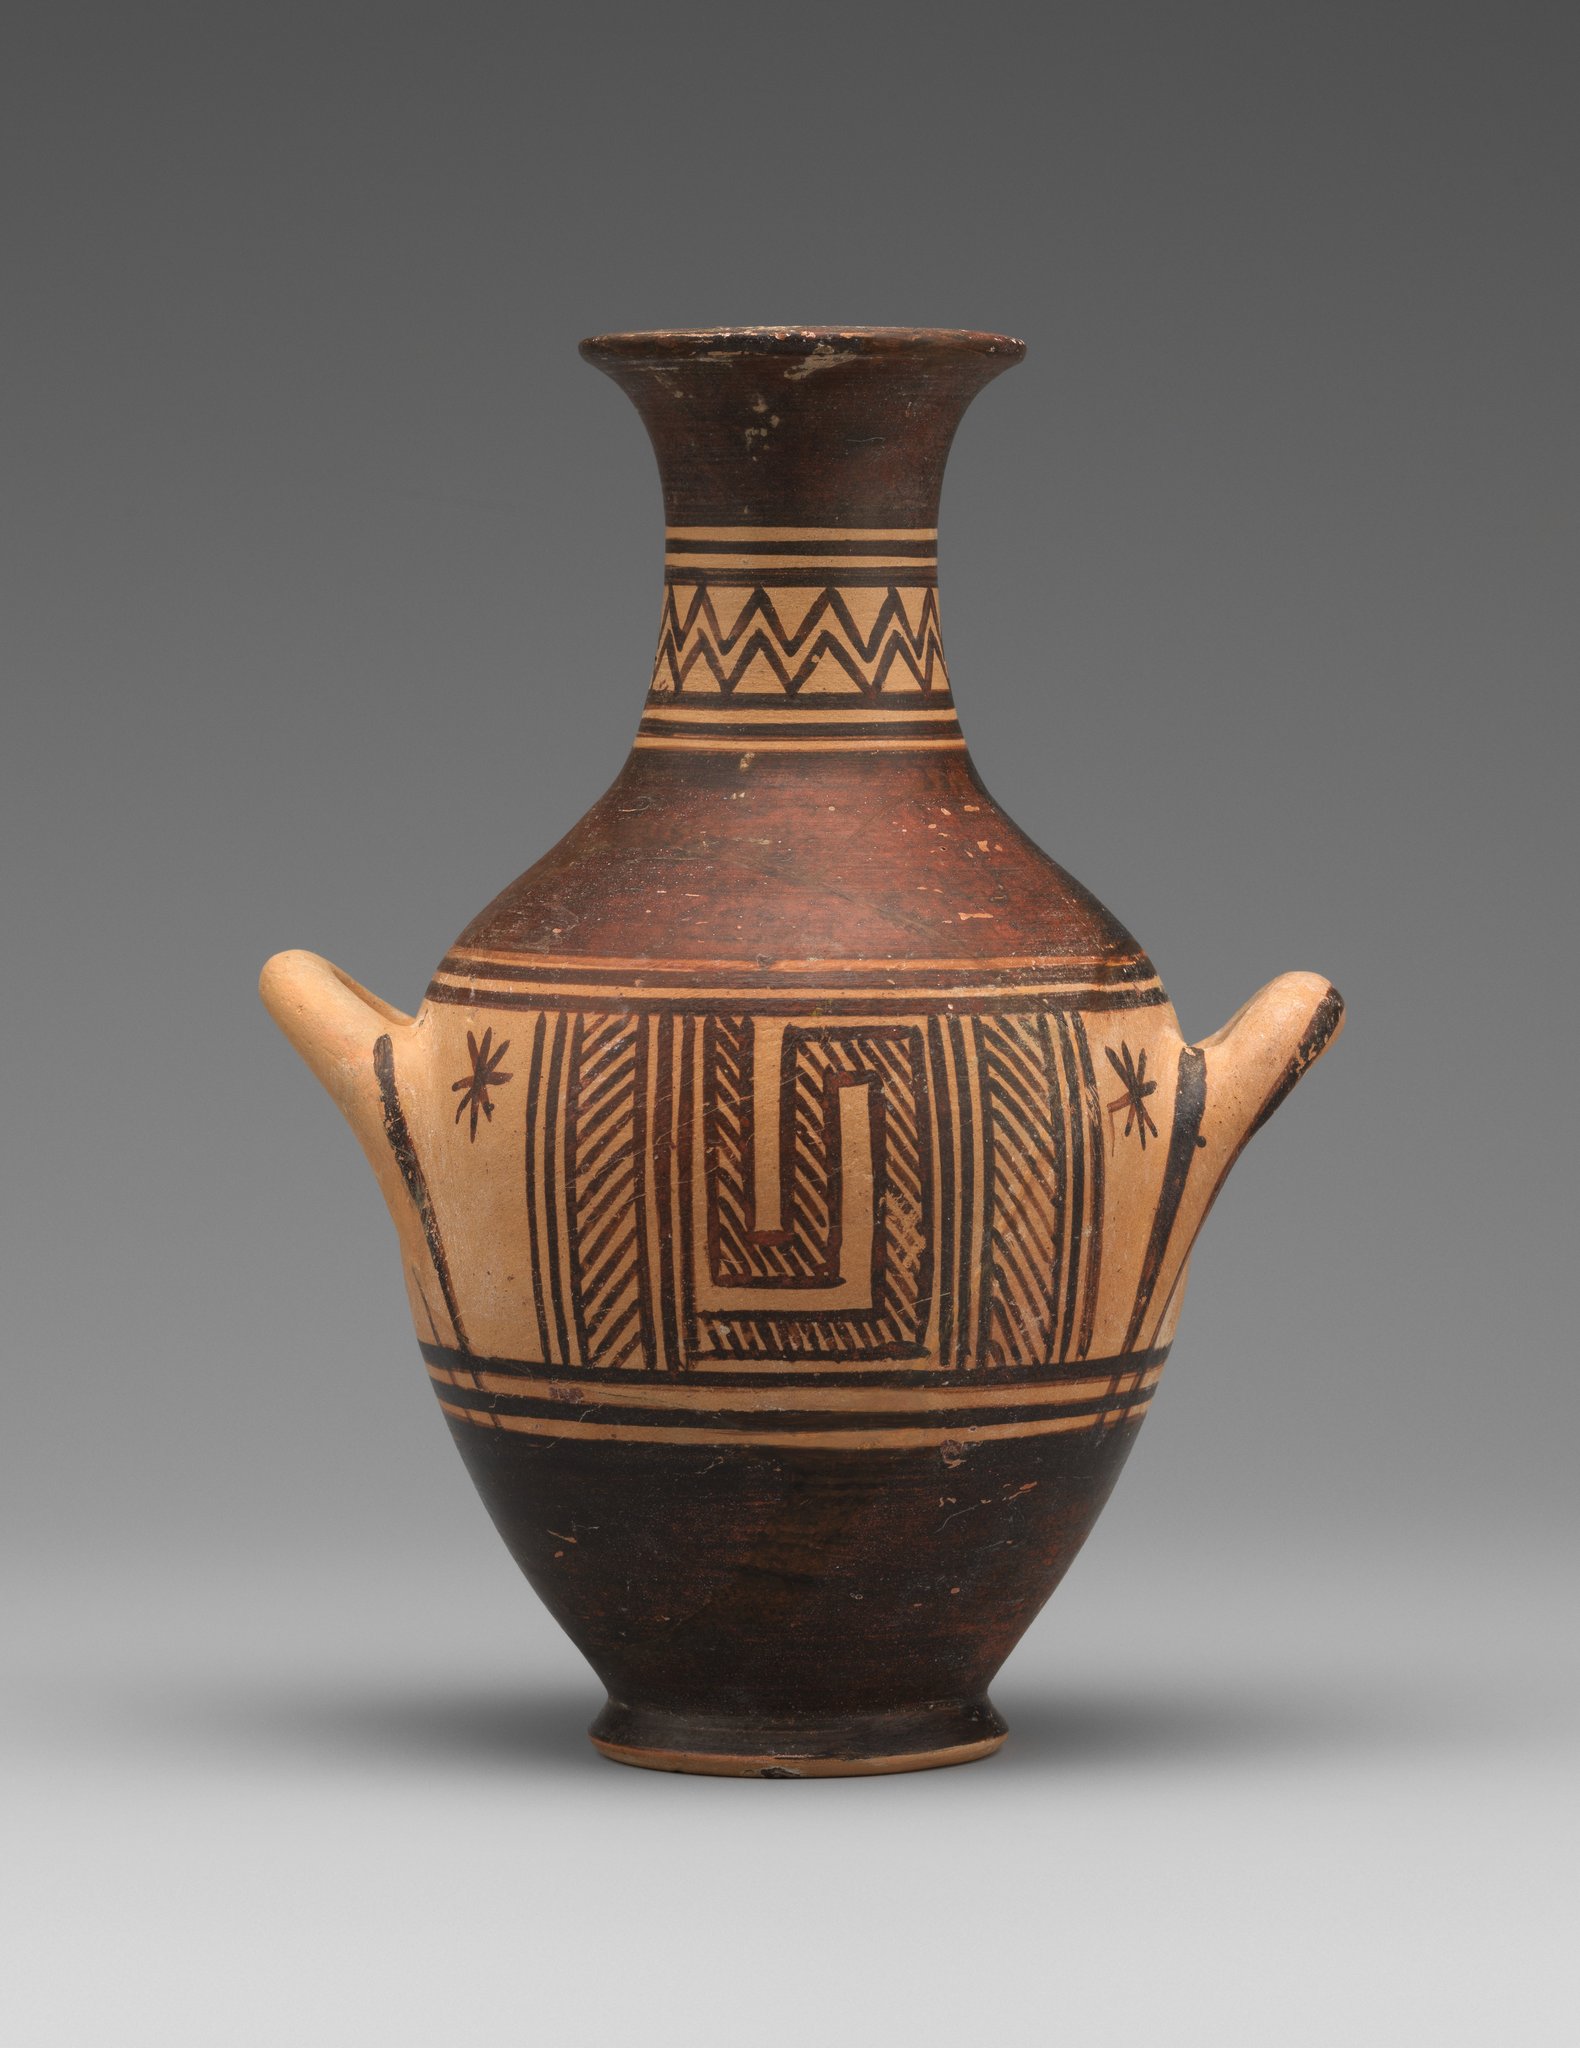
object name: amphora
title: Small terracotta amphora (jar)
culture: greek, attic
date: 800-750 BCE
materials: terracotta